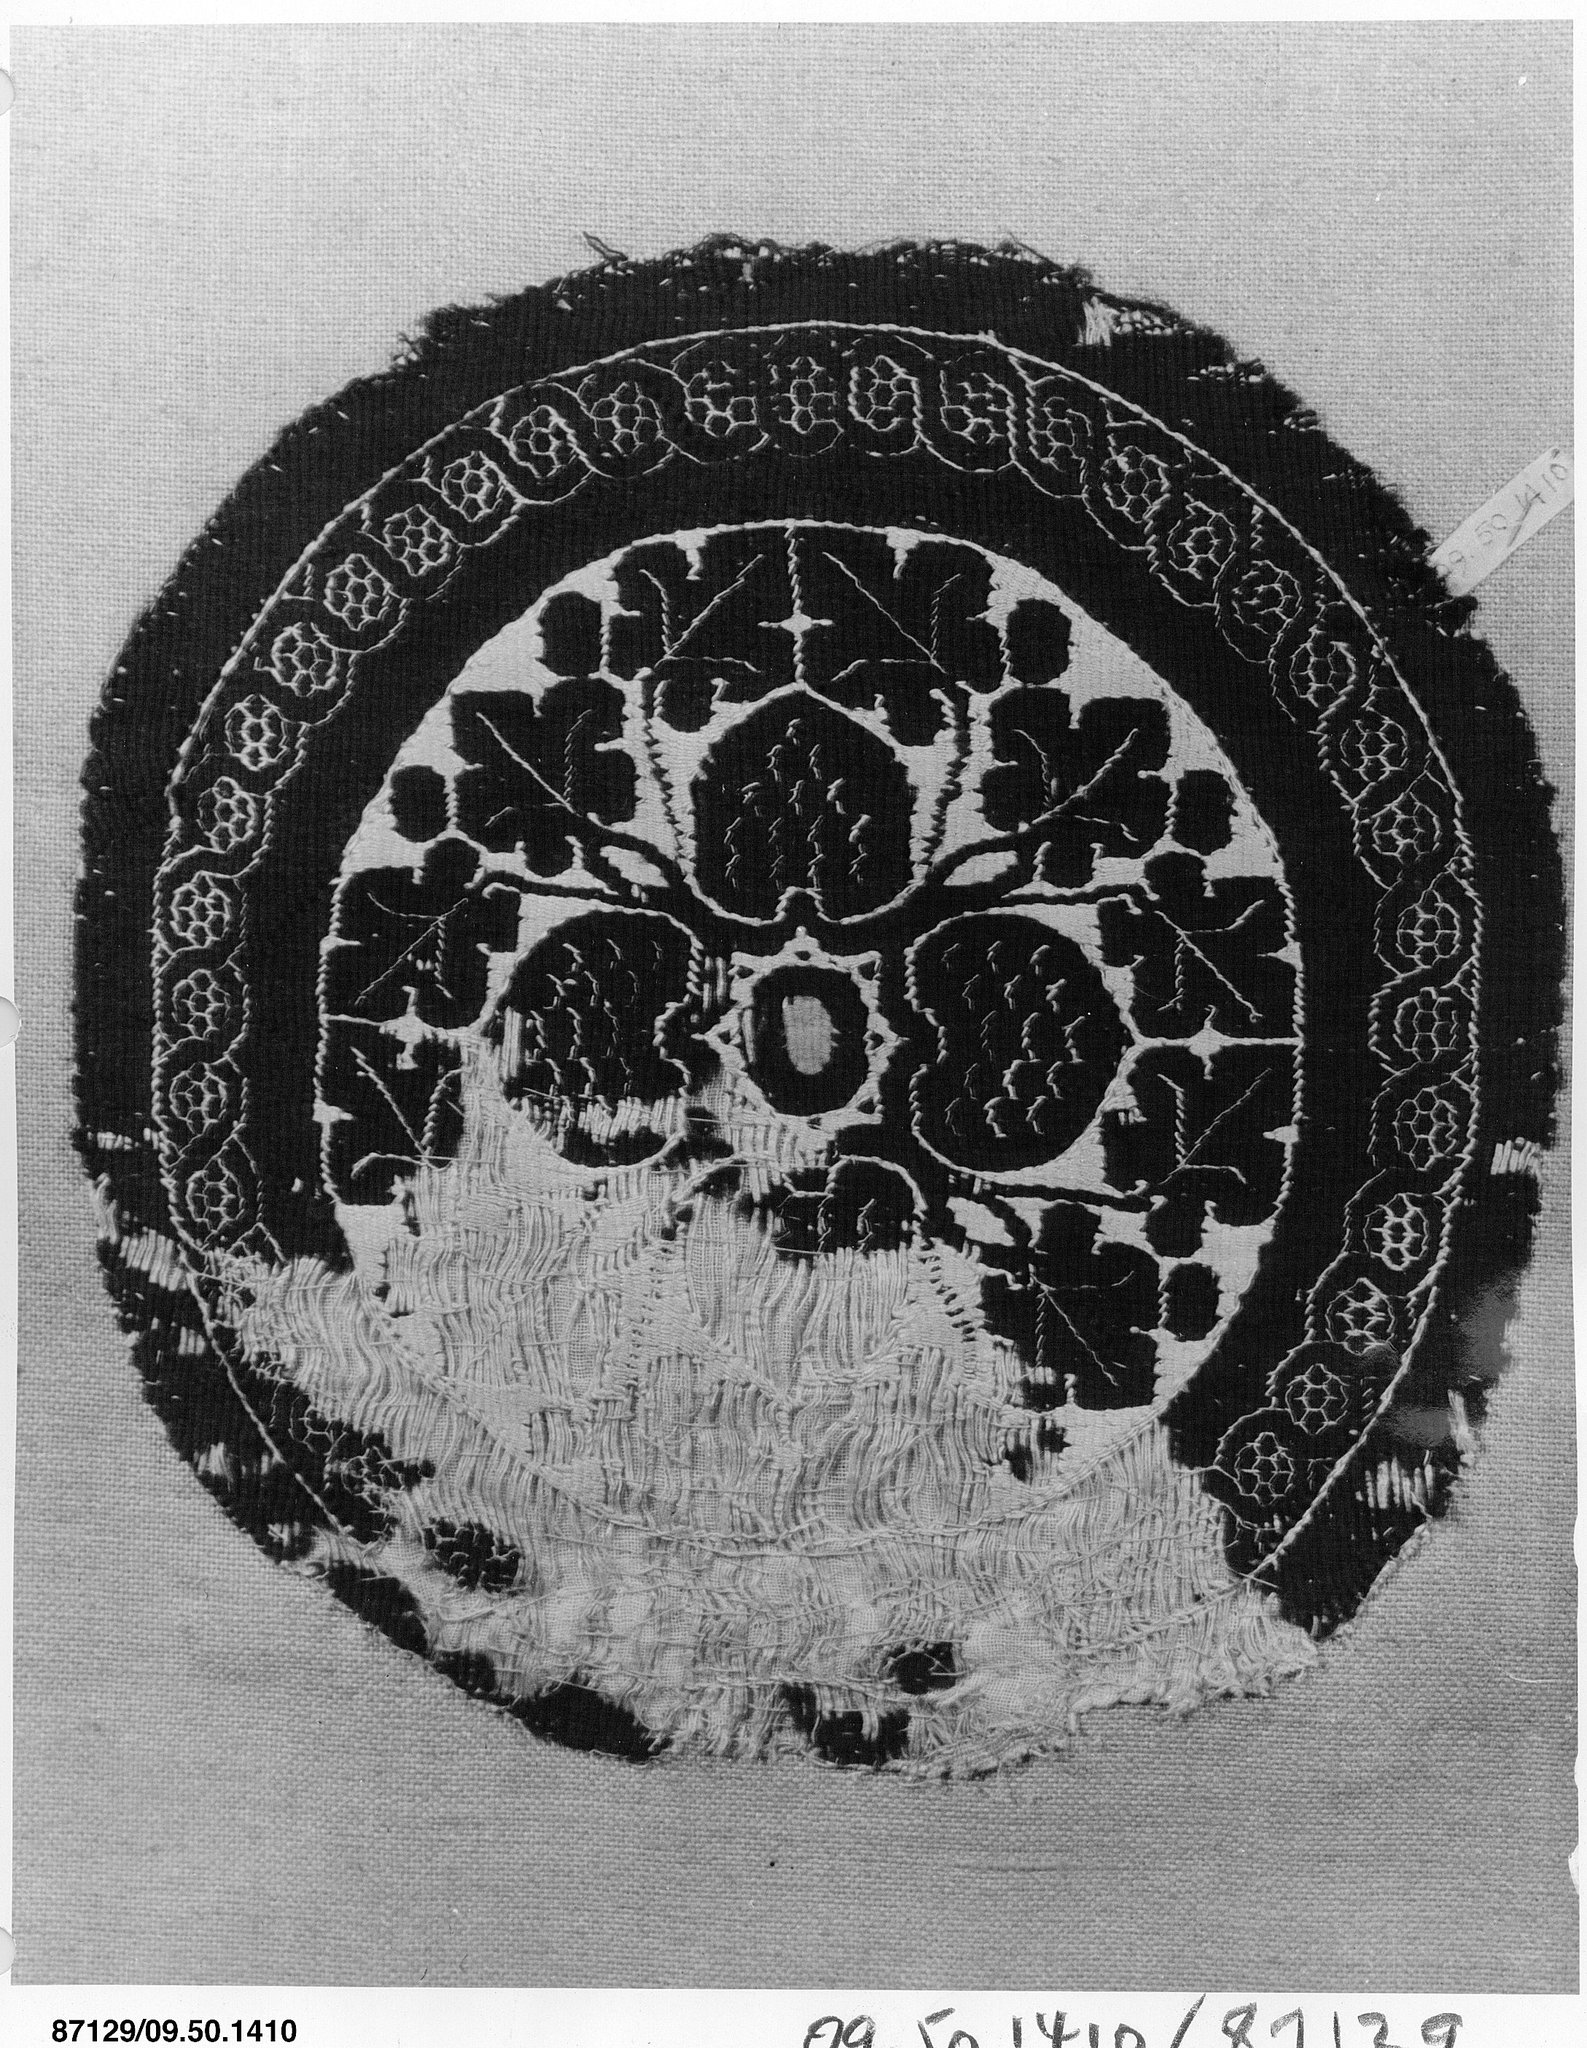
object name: roundel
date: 301-400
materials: linen, wool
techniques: weave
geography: egypt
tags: leaves